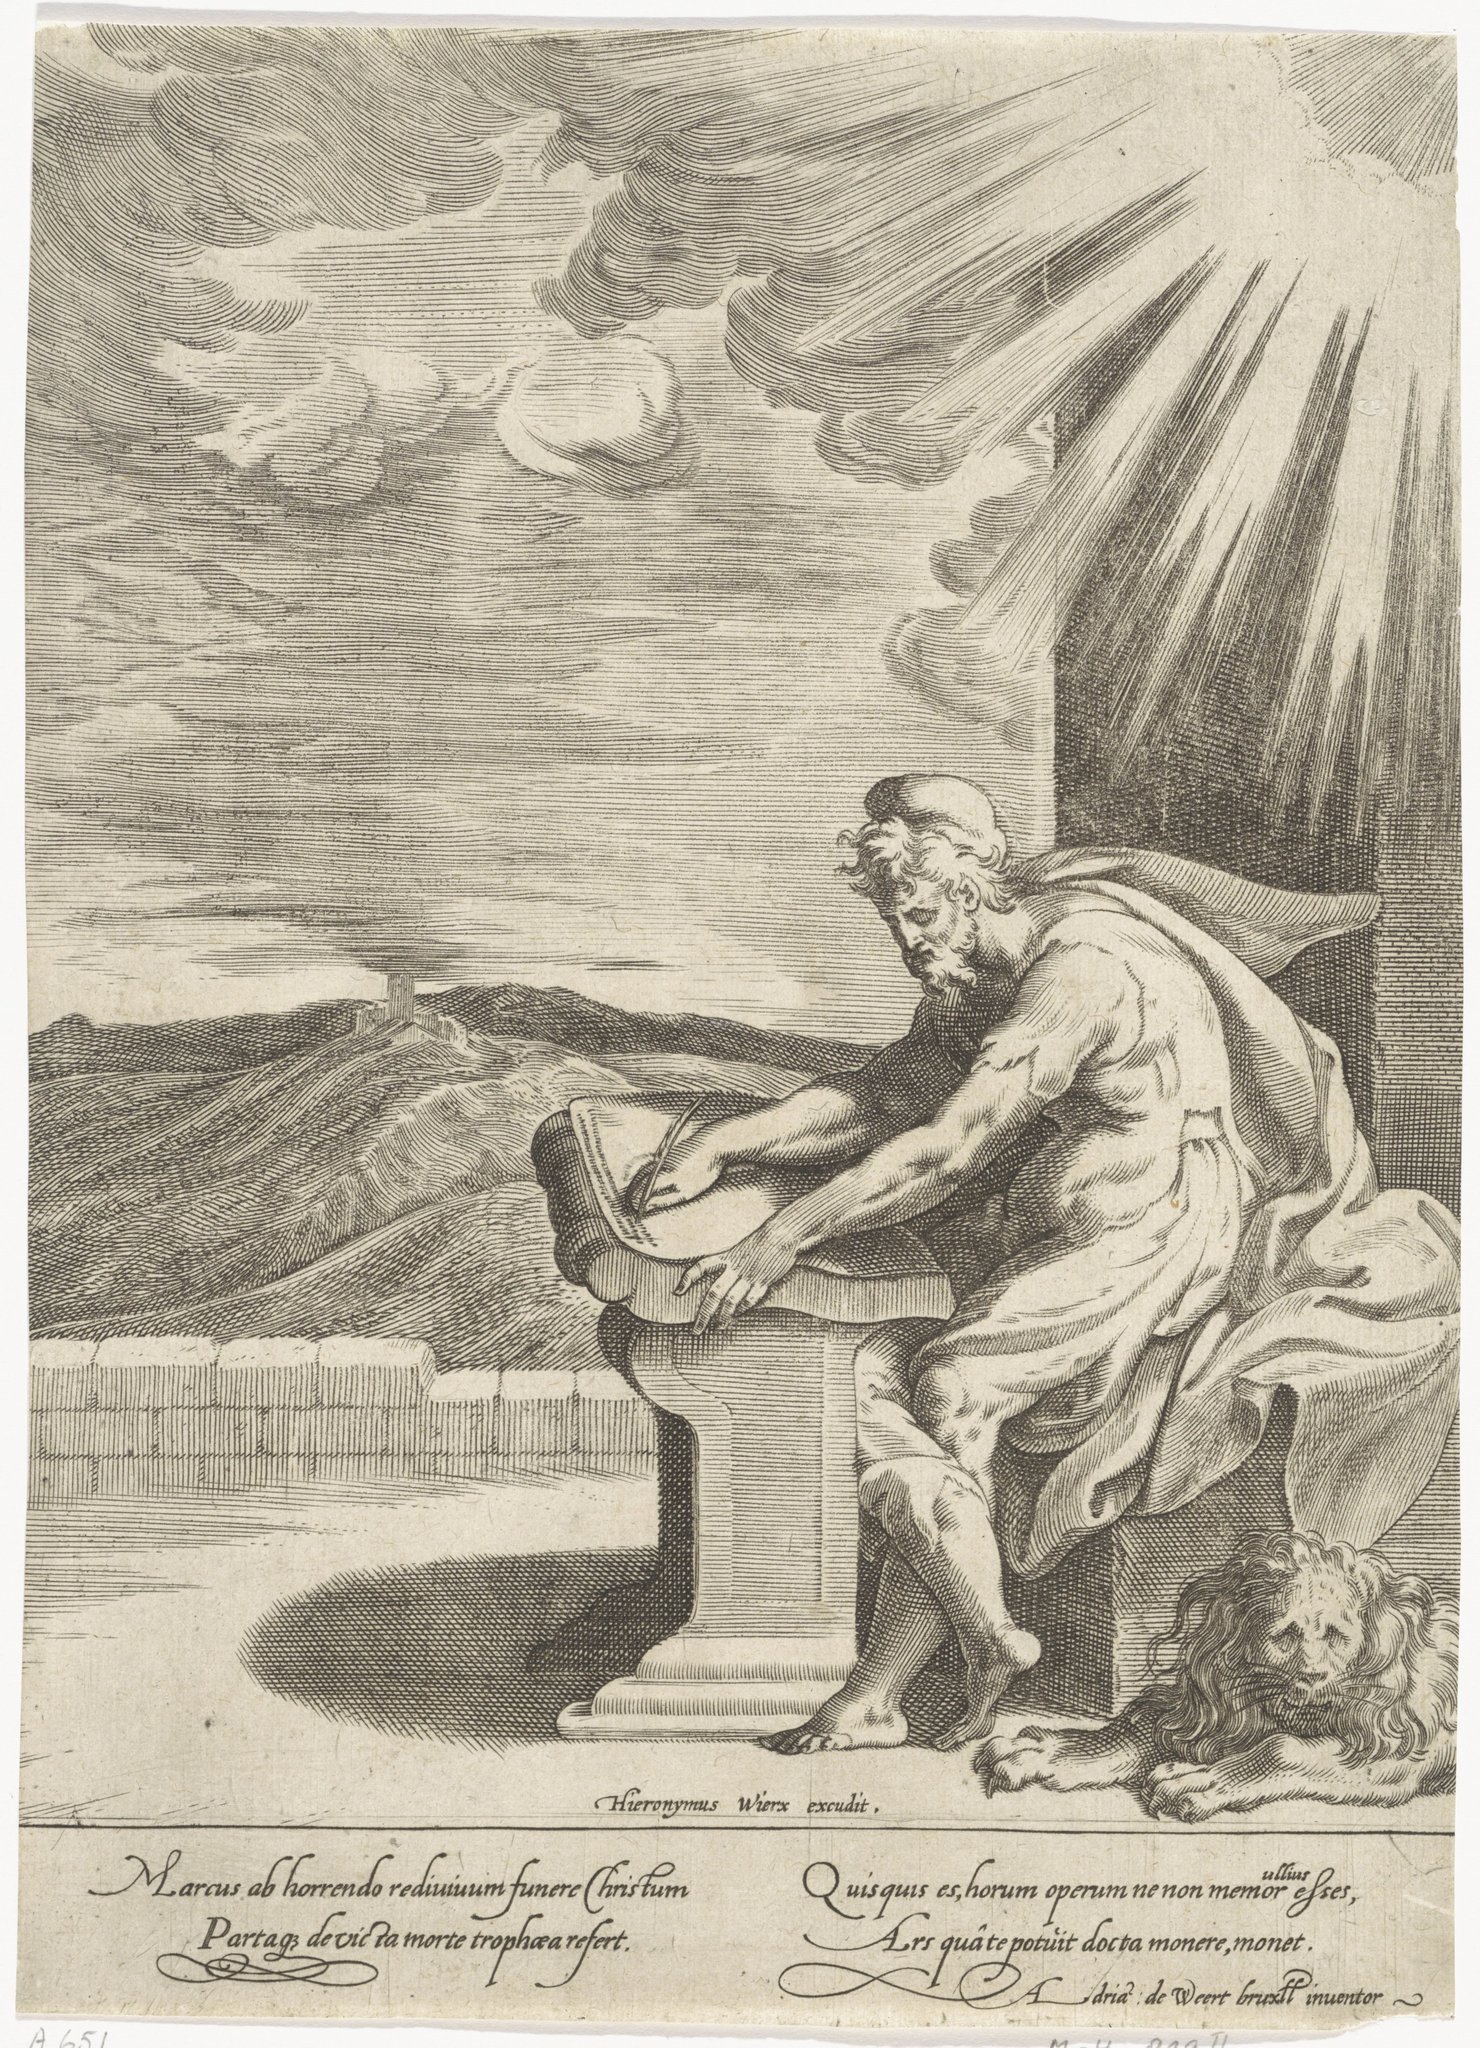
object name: print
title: Vier evangelisten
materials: paper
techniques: engraving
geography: southern netherlands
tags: st. mark the evangelist writing the gospel, usually a (winged) lion present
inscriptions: signature: ‘Adria de Weert bruxll~inventor’ Lugt, collector's mark: 2228, caption: ‘Marcus ab horrendo...docta monere, monet’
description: De evangelist Marcus zit aan zijn schrijftafel en schrijft zijn evangelie. Aan zijn voeten ligt de leeuw. Op de achtergrond een gezicht op een heuvelachtig landschap. In de marge een vierregelig onderschrift, in twee kolommen, in het Latijn.